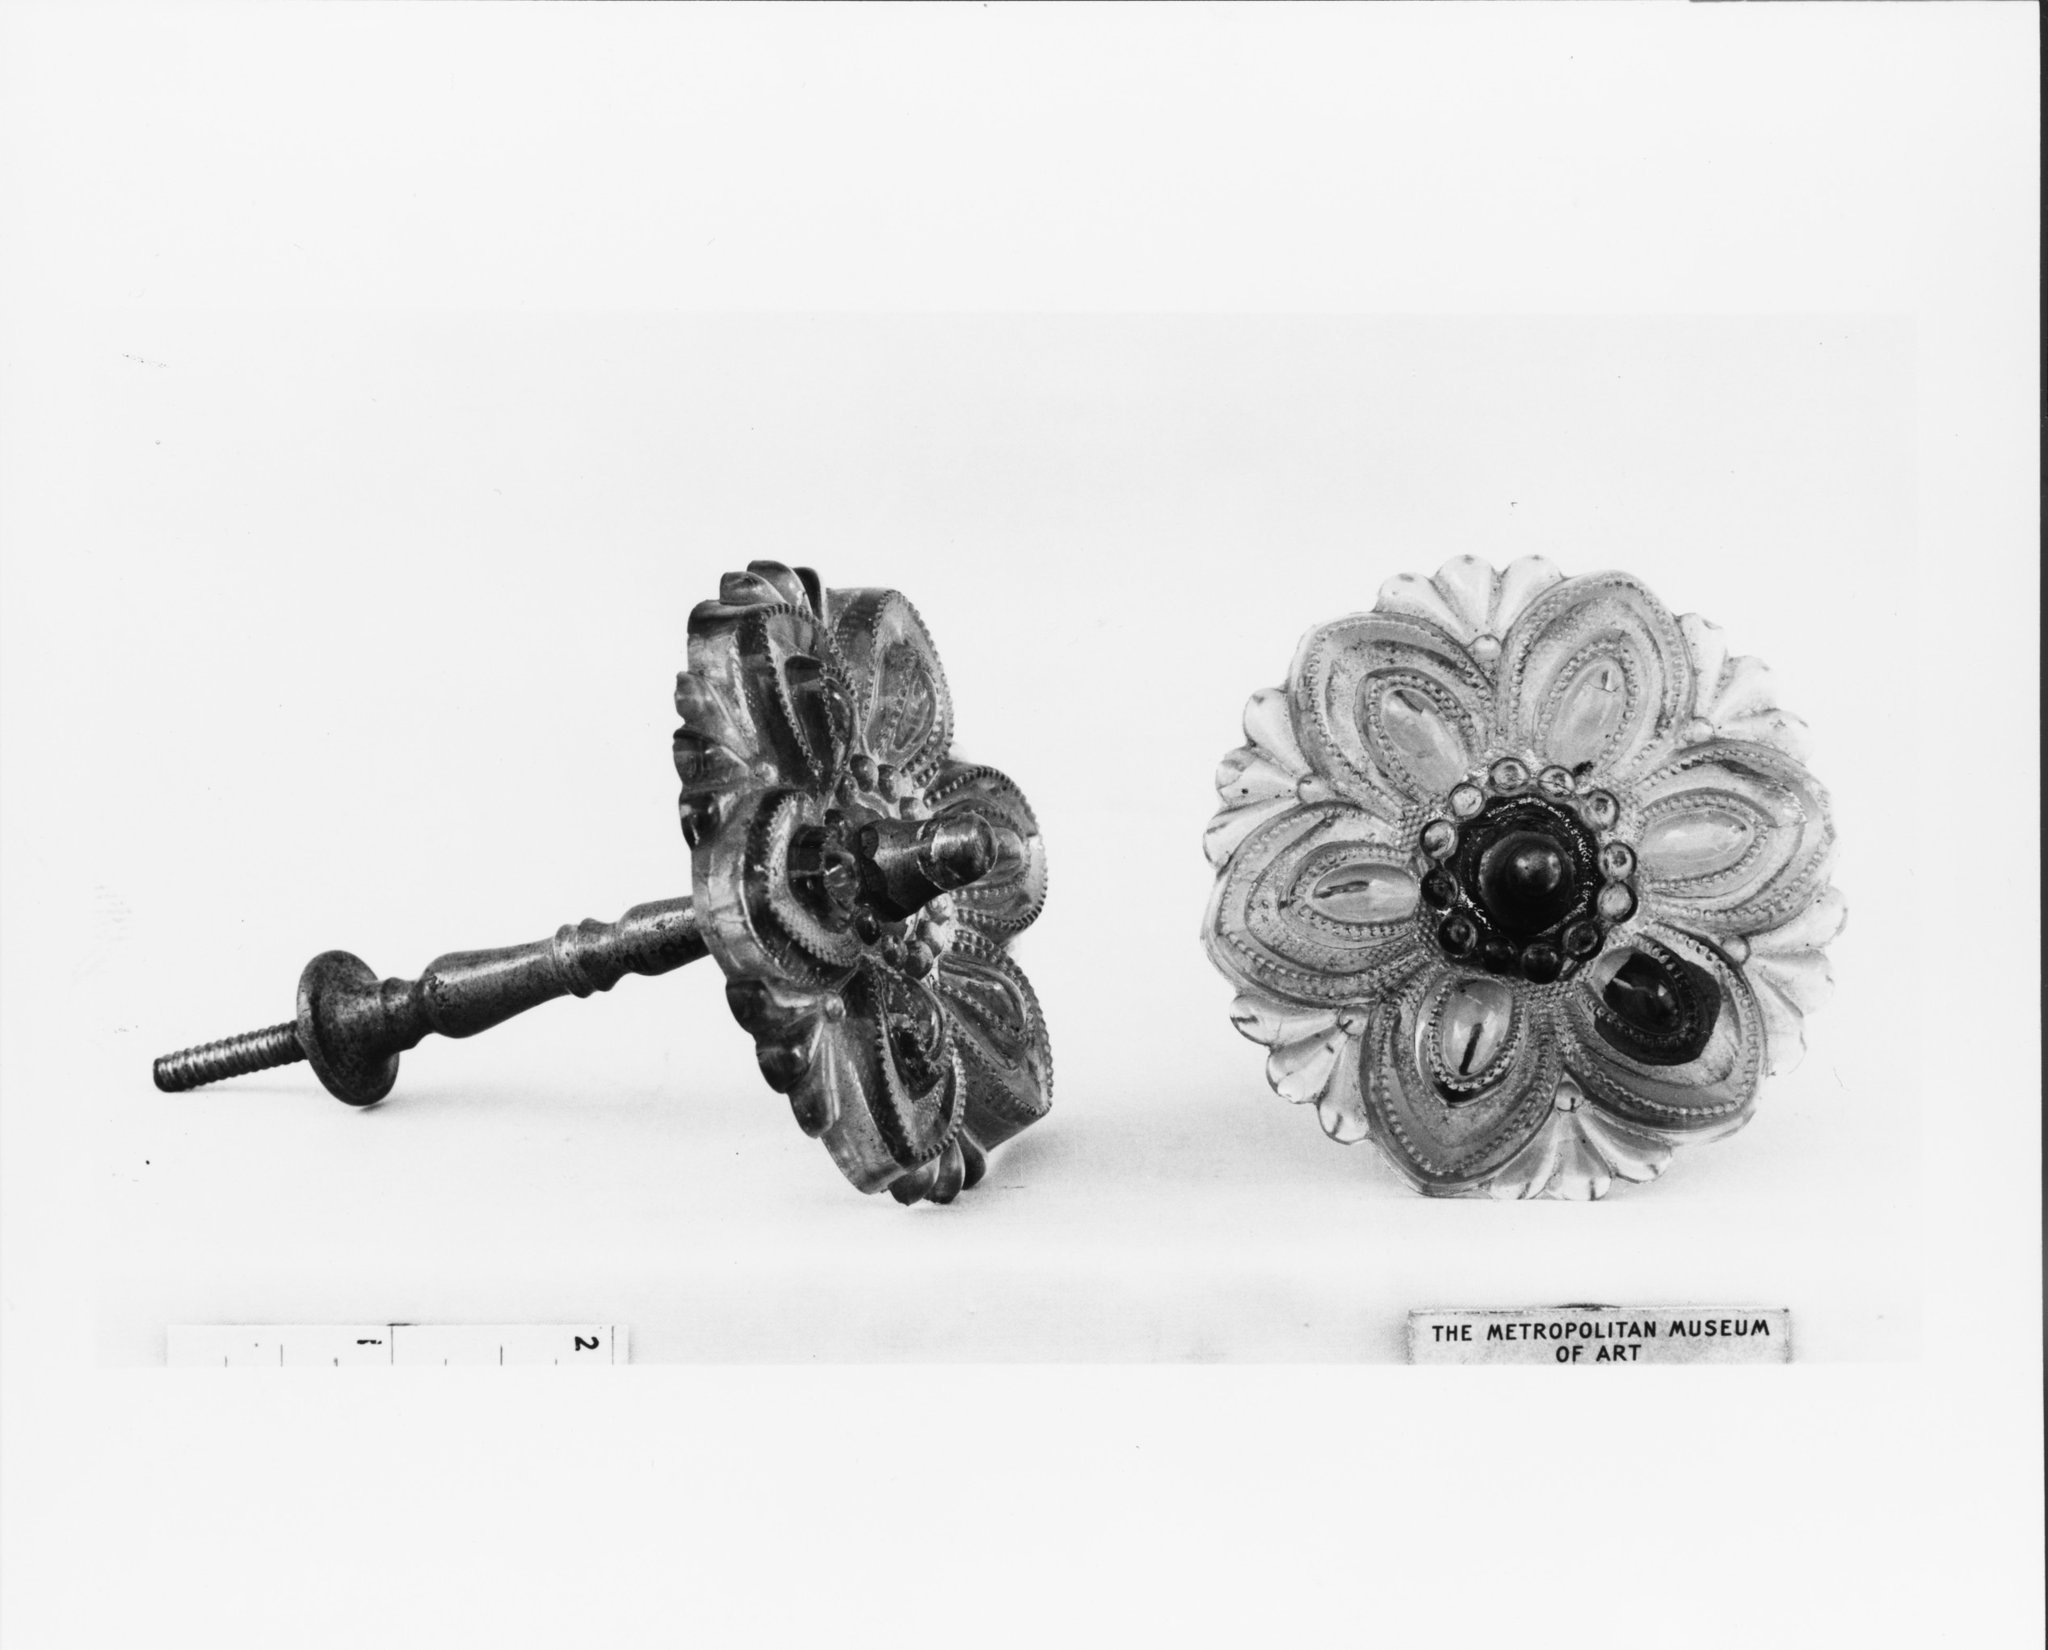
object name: curtain knob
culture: american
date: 1840-1860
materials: brass, glass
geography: united states